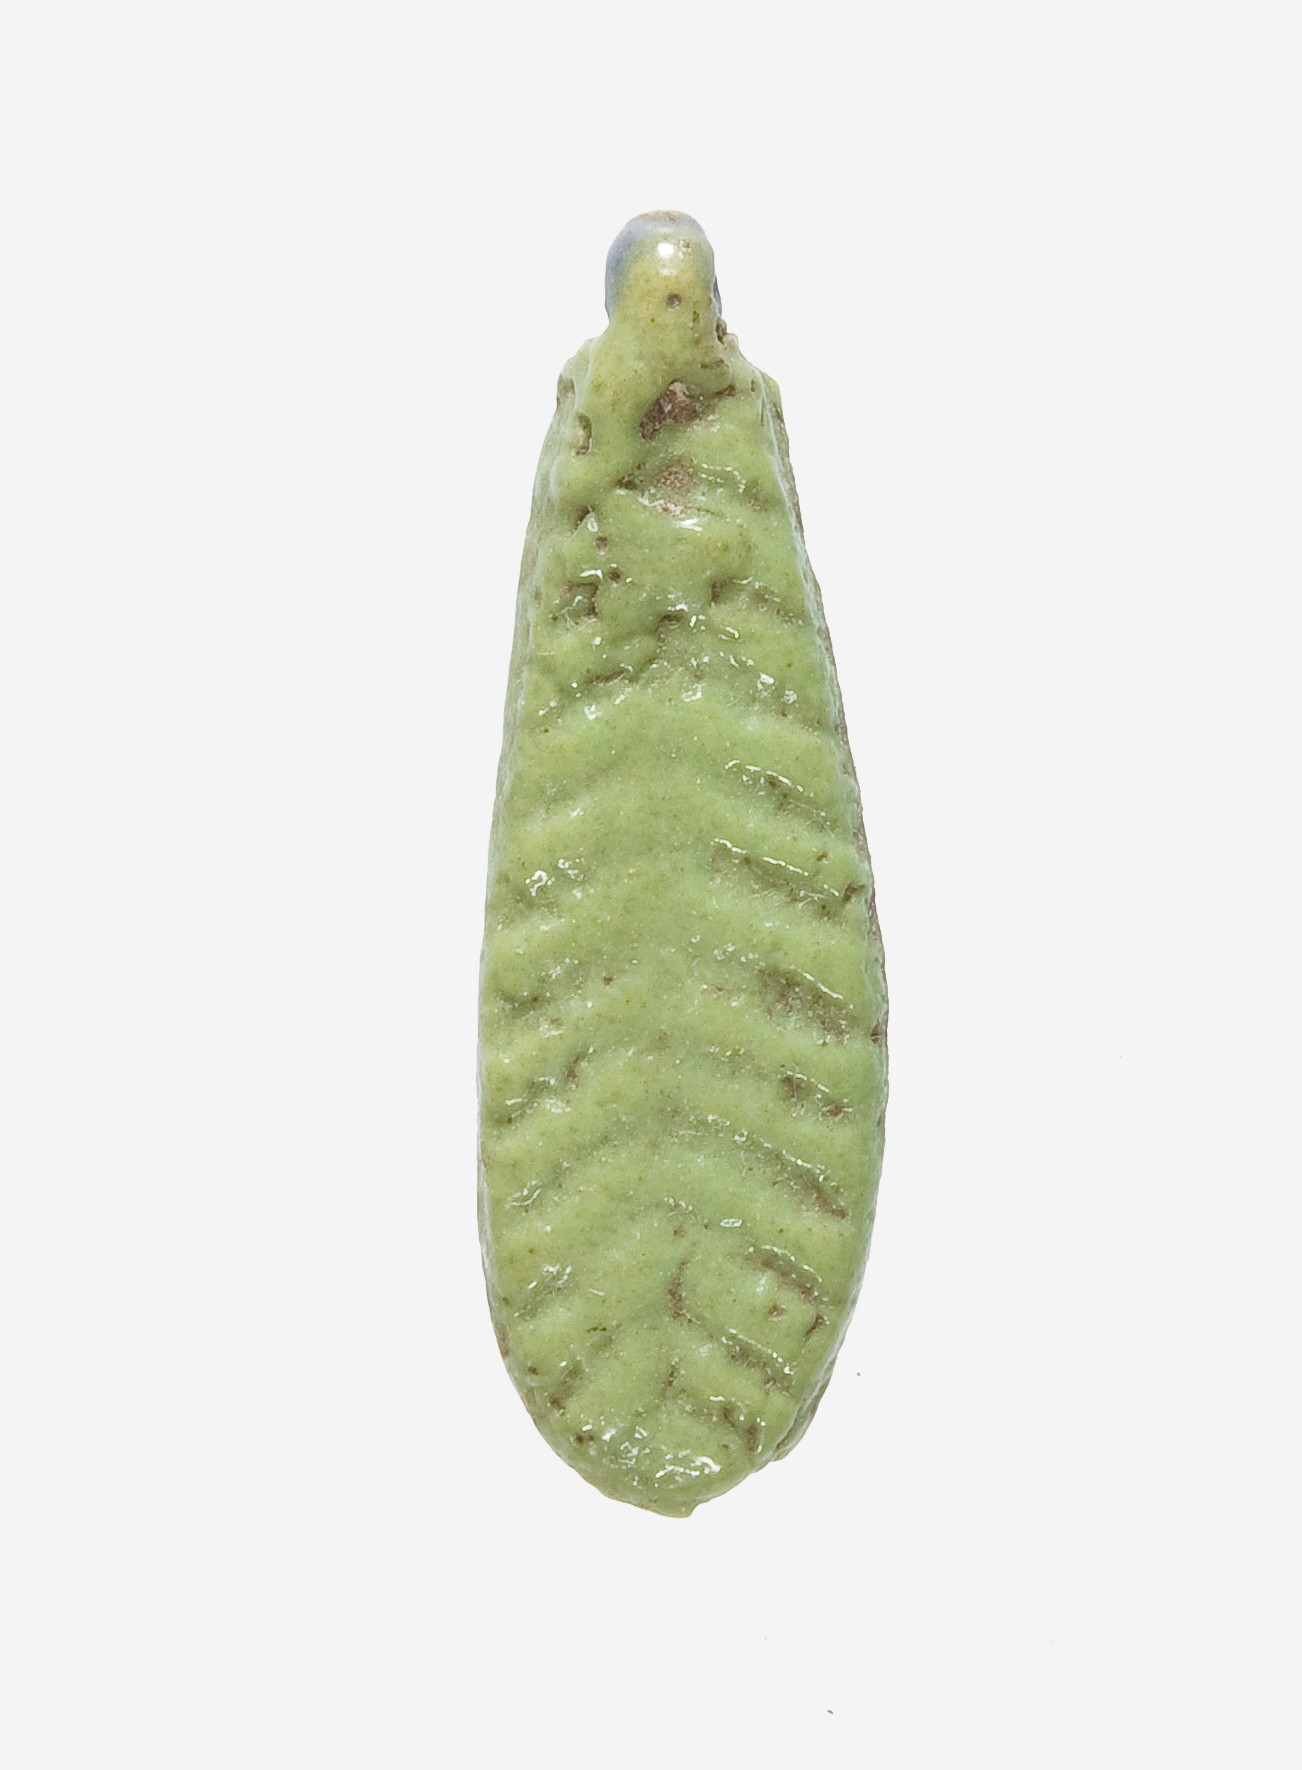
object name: pendant, leaf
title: Leaf Pendant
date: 1390-1352 BCE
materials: faience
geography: egypt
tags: leaves